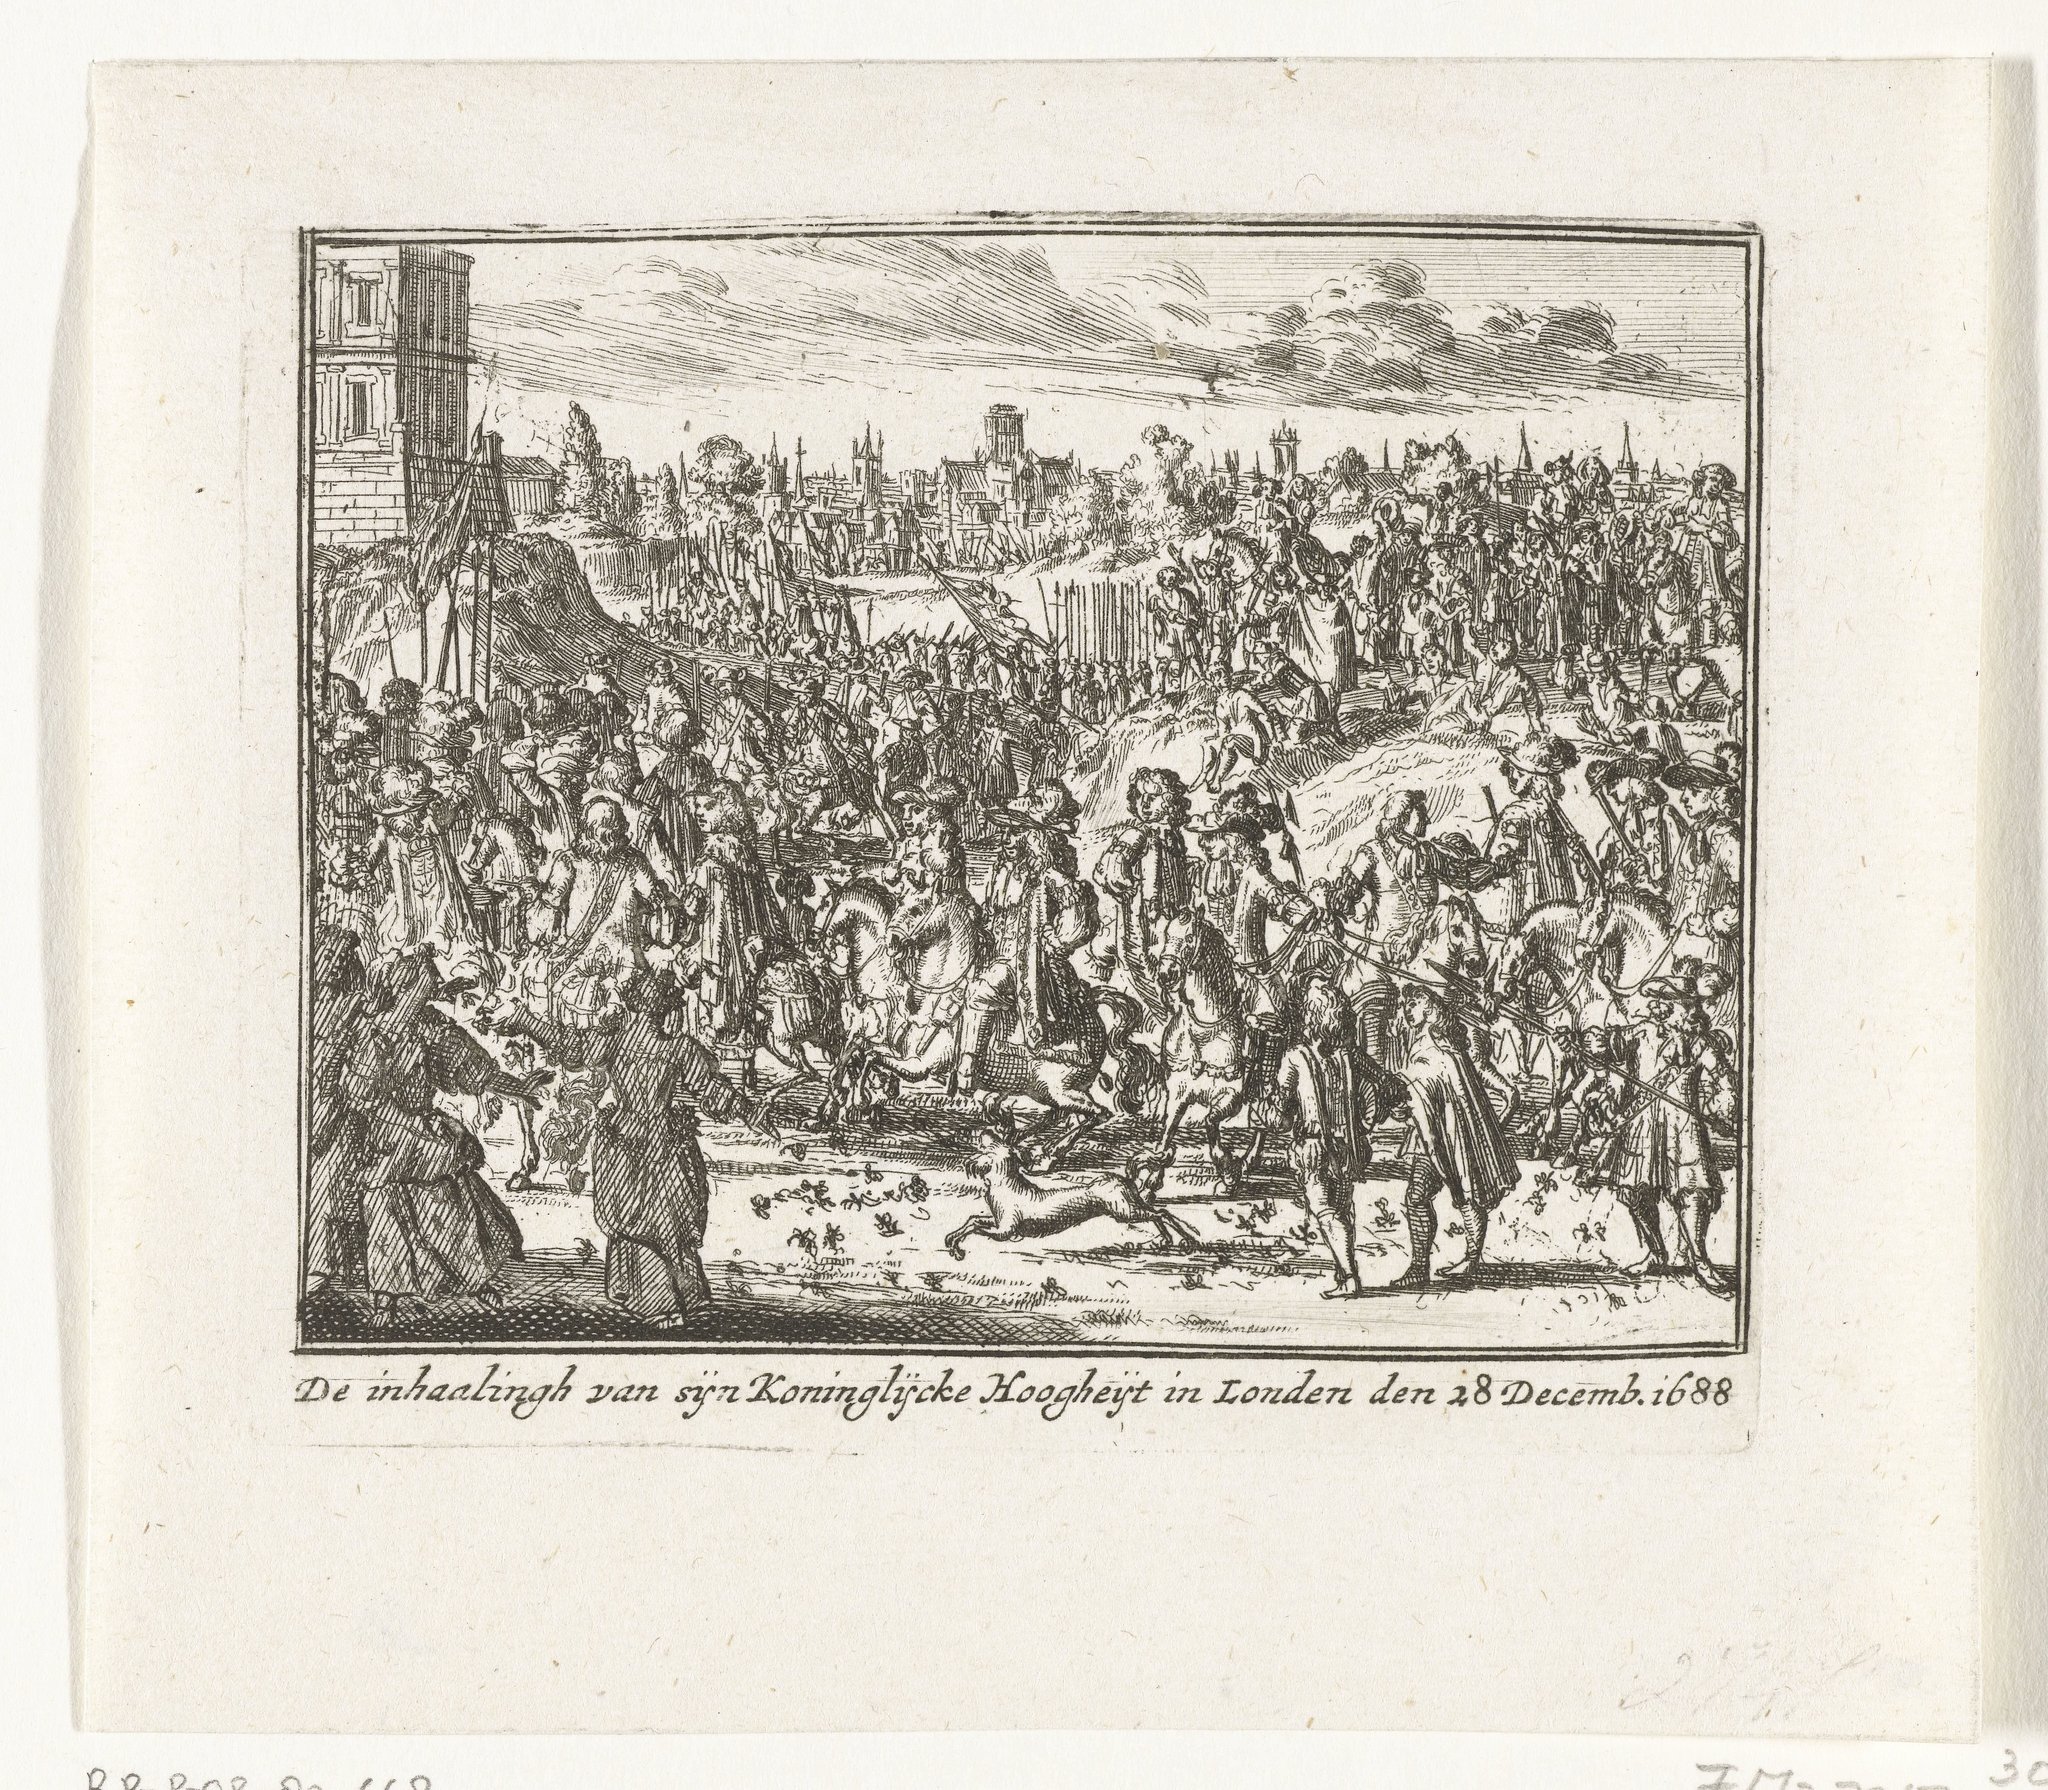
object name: history print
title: De inhaalingh van syn Koninglycke Hoogheyt in Londen den 28 Decemb. 1688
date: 1711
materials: paper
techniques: engraving, etching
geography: northern netherlands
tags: william iii (prince of orange and king of england, scotland, and ireland), triumphal entry and public reception, pageant, 'entrée solennelle', 'joyeuse entrée', london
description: Feestelijk ontvangst van prins Willem III in London op 28 december 1688. Onderdeel van een serie over de lotgevallen van het Engelse koningshuis van Stuart van 1558-1711, waarvan hier zijn opgenomen zestien prenten over de strijd tussen Jacobus II en Willem III in de jaren 1688-1689.